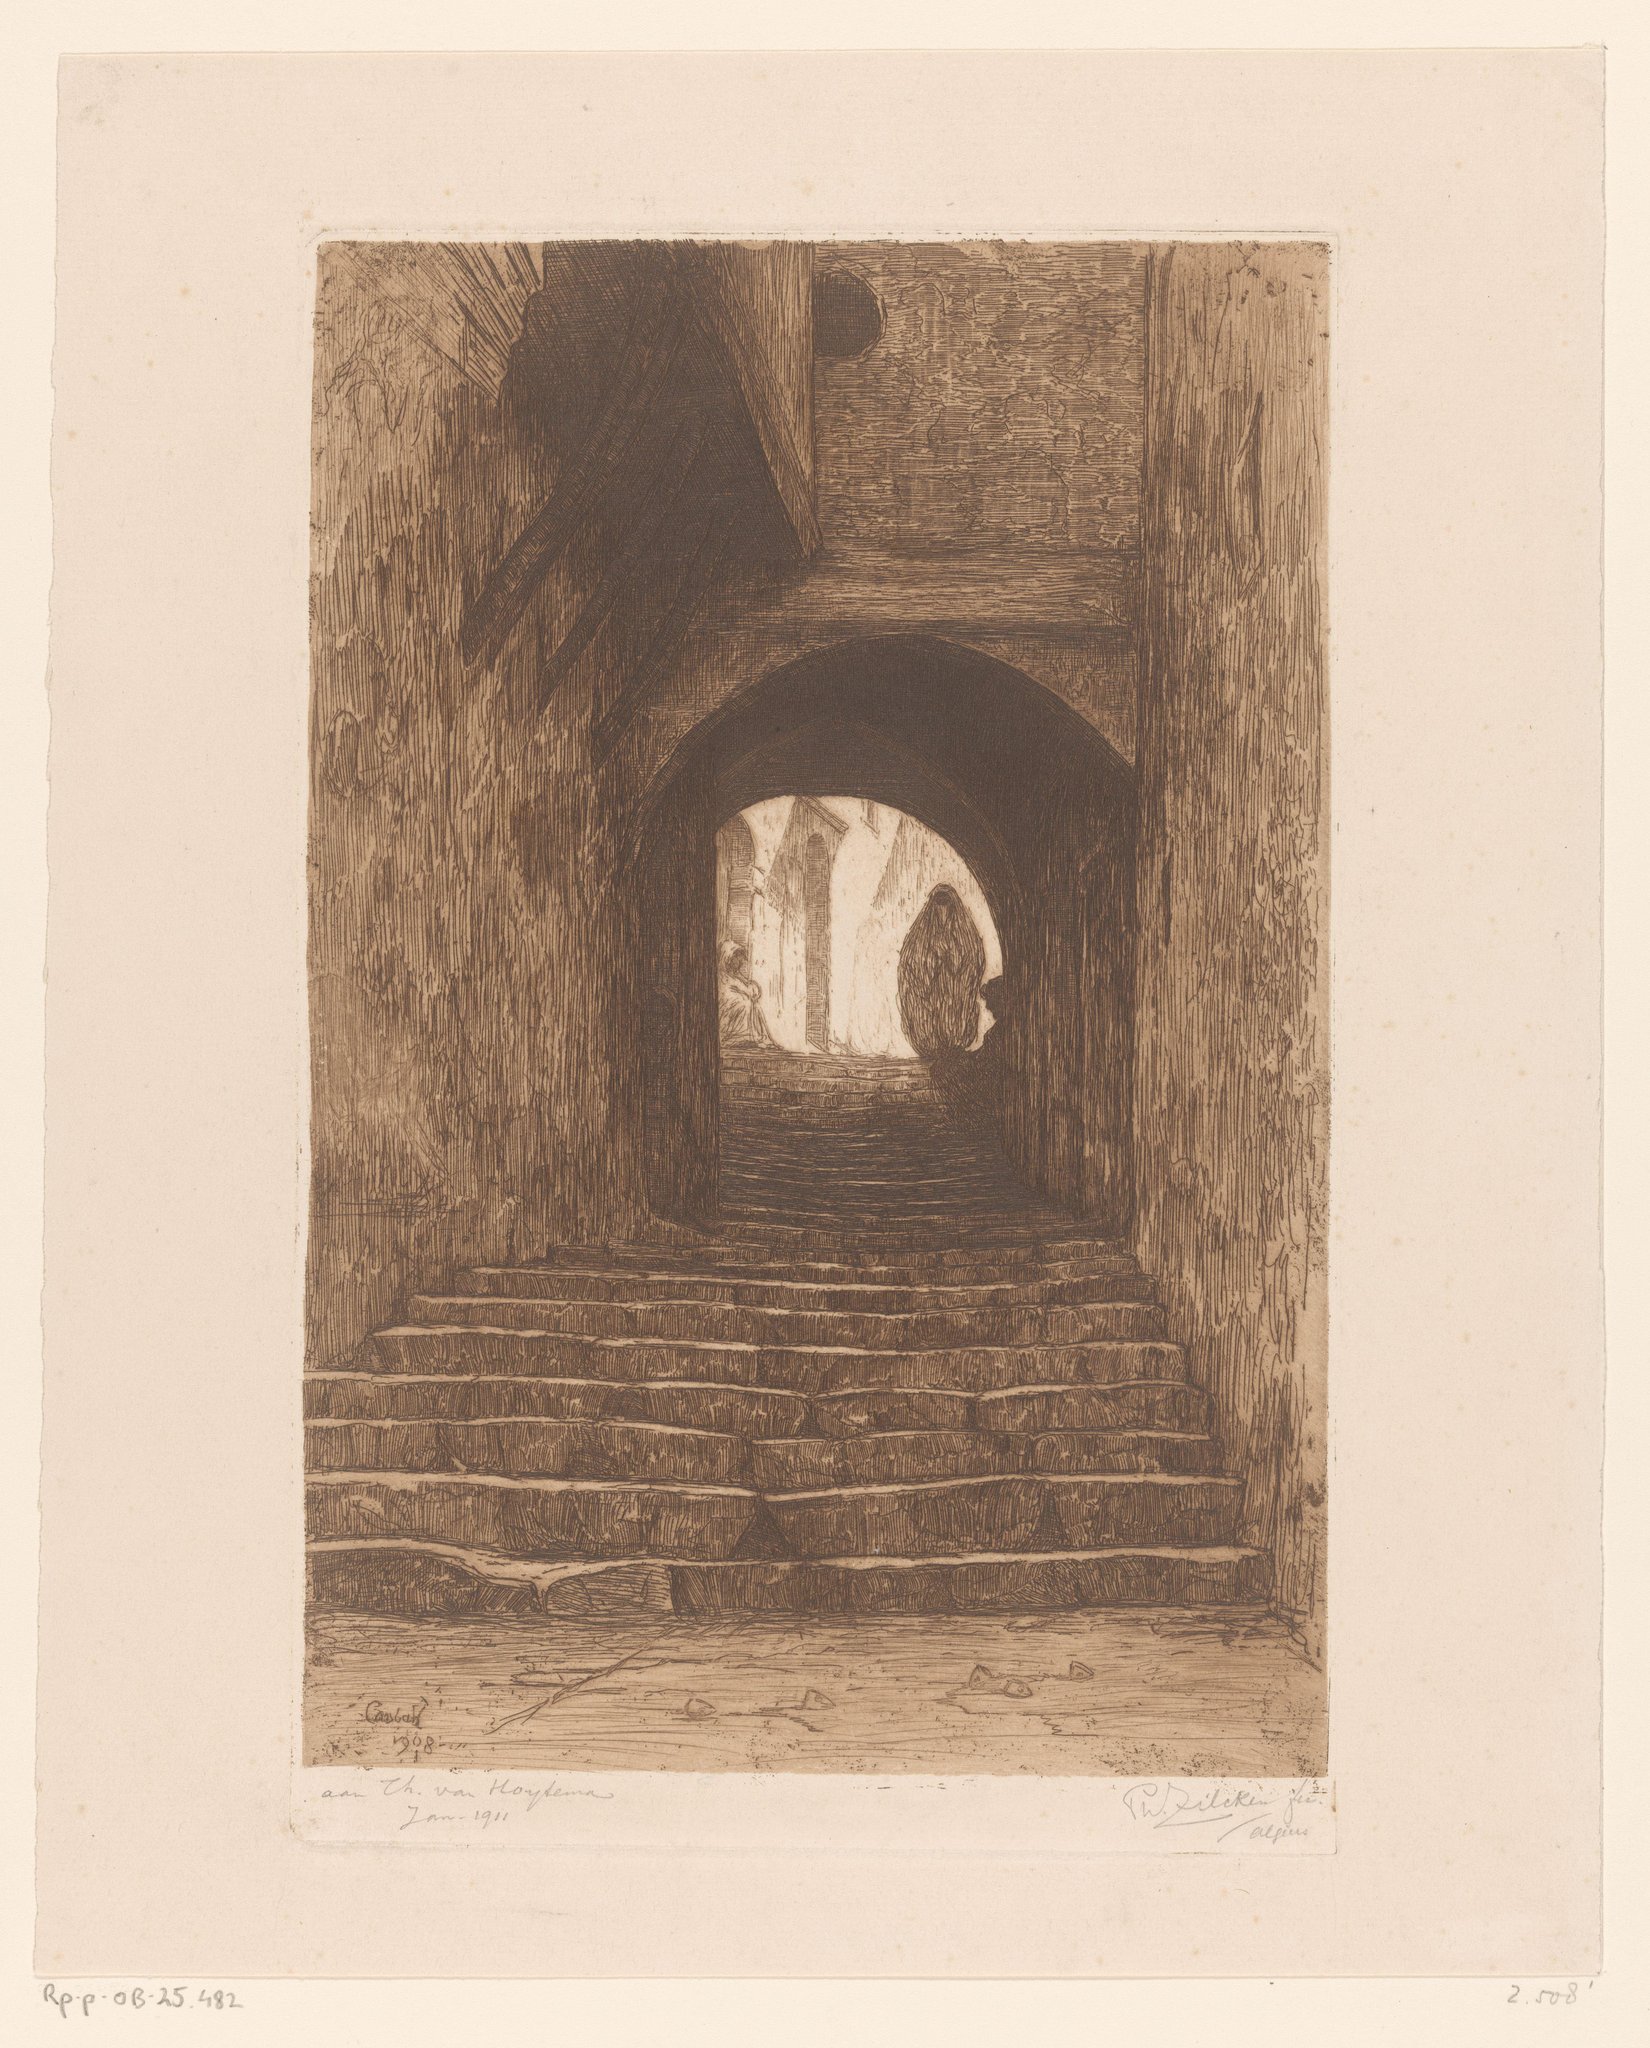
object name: print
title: Rue d'Heliopolis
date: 1908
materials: paper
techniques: drypoint, intaglio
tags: sloping street; street with steps or stairs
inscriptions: collector's mark: Lugt 2228, collector's mark: ‘L.A. de Vries’